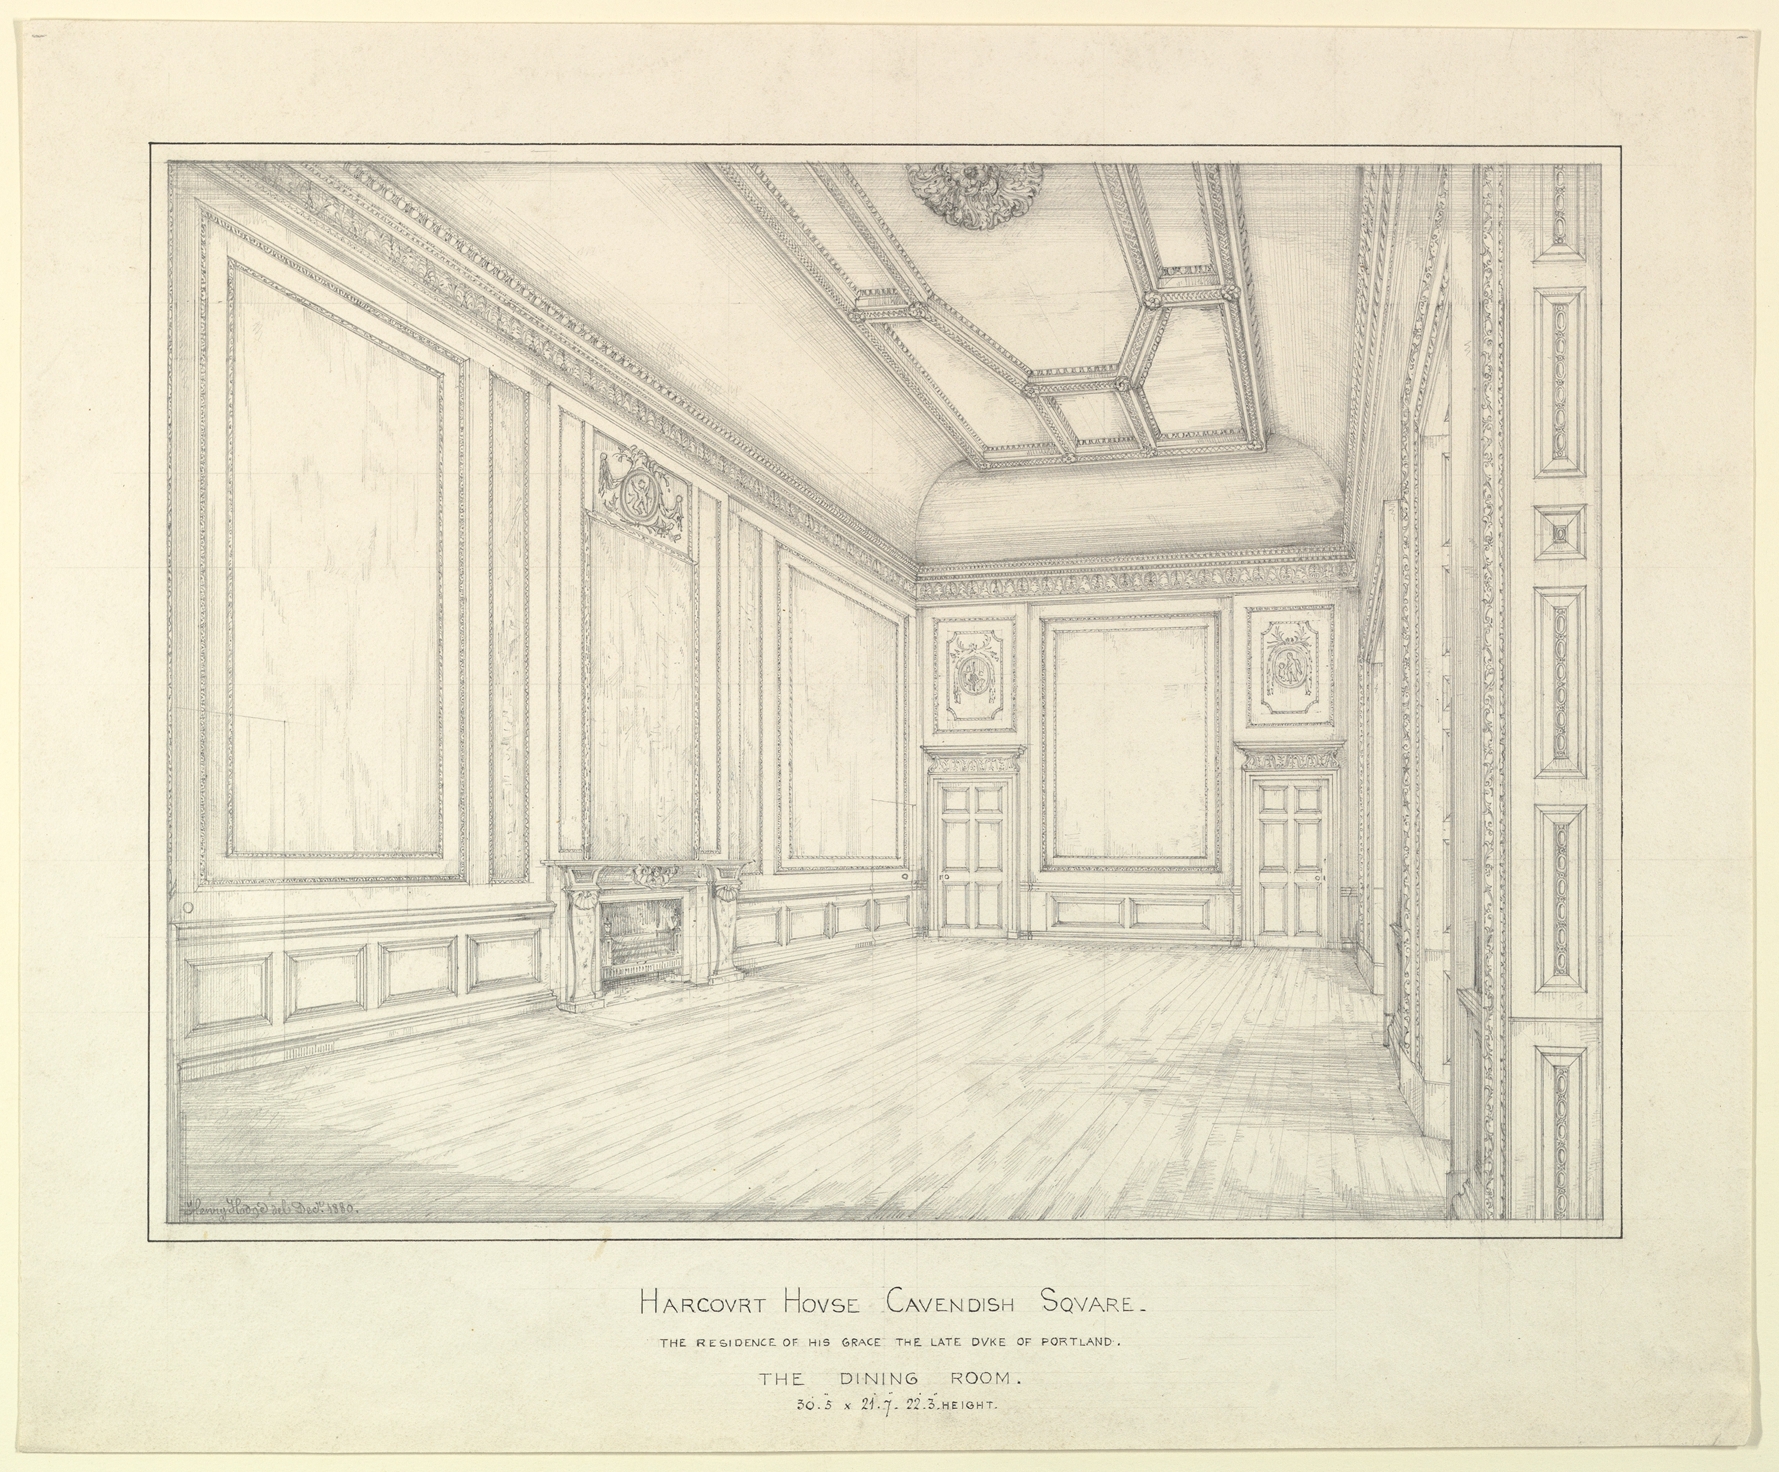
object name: drawing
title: Harcourt House Cavendish Square, The Dining Room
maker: henry hodge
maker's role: artist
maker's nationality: british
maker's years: 1824-1825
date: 1880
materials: graphite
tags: interiors